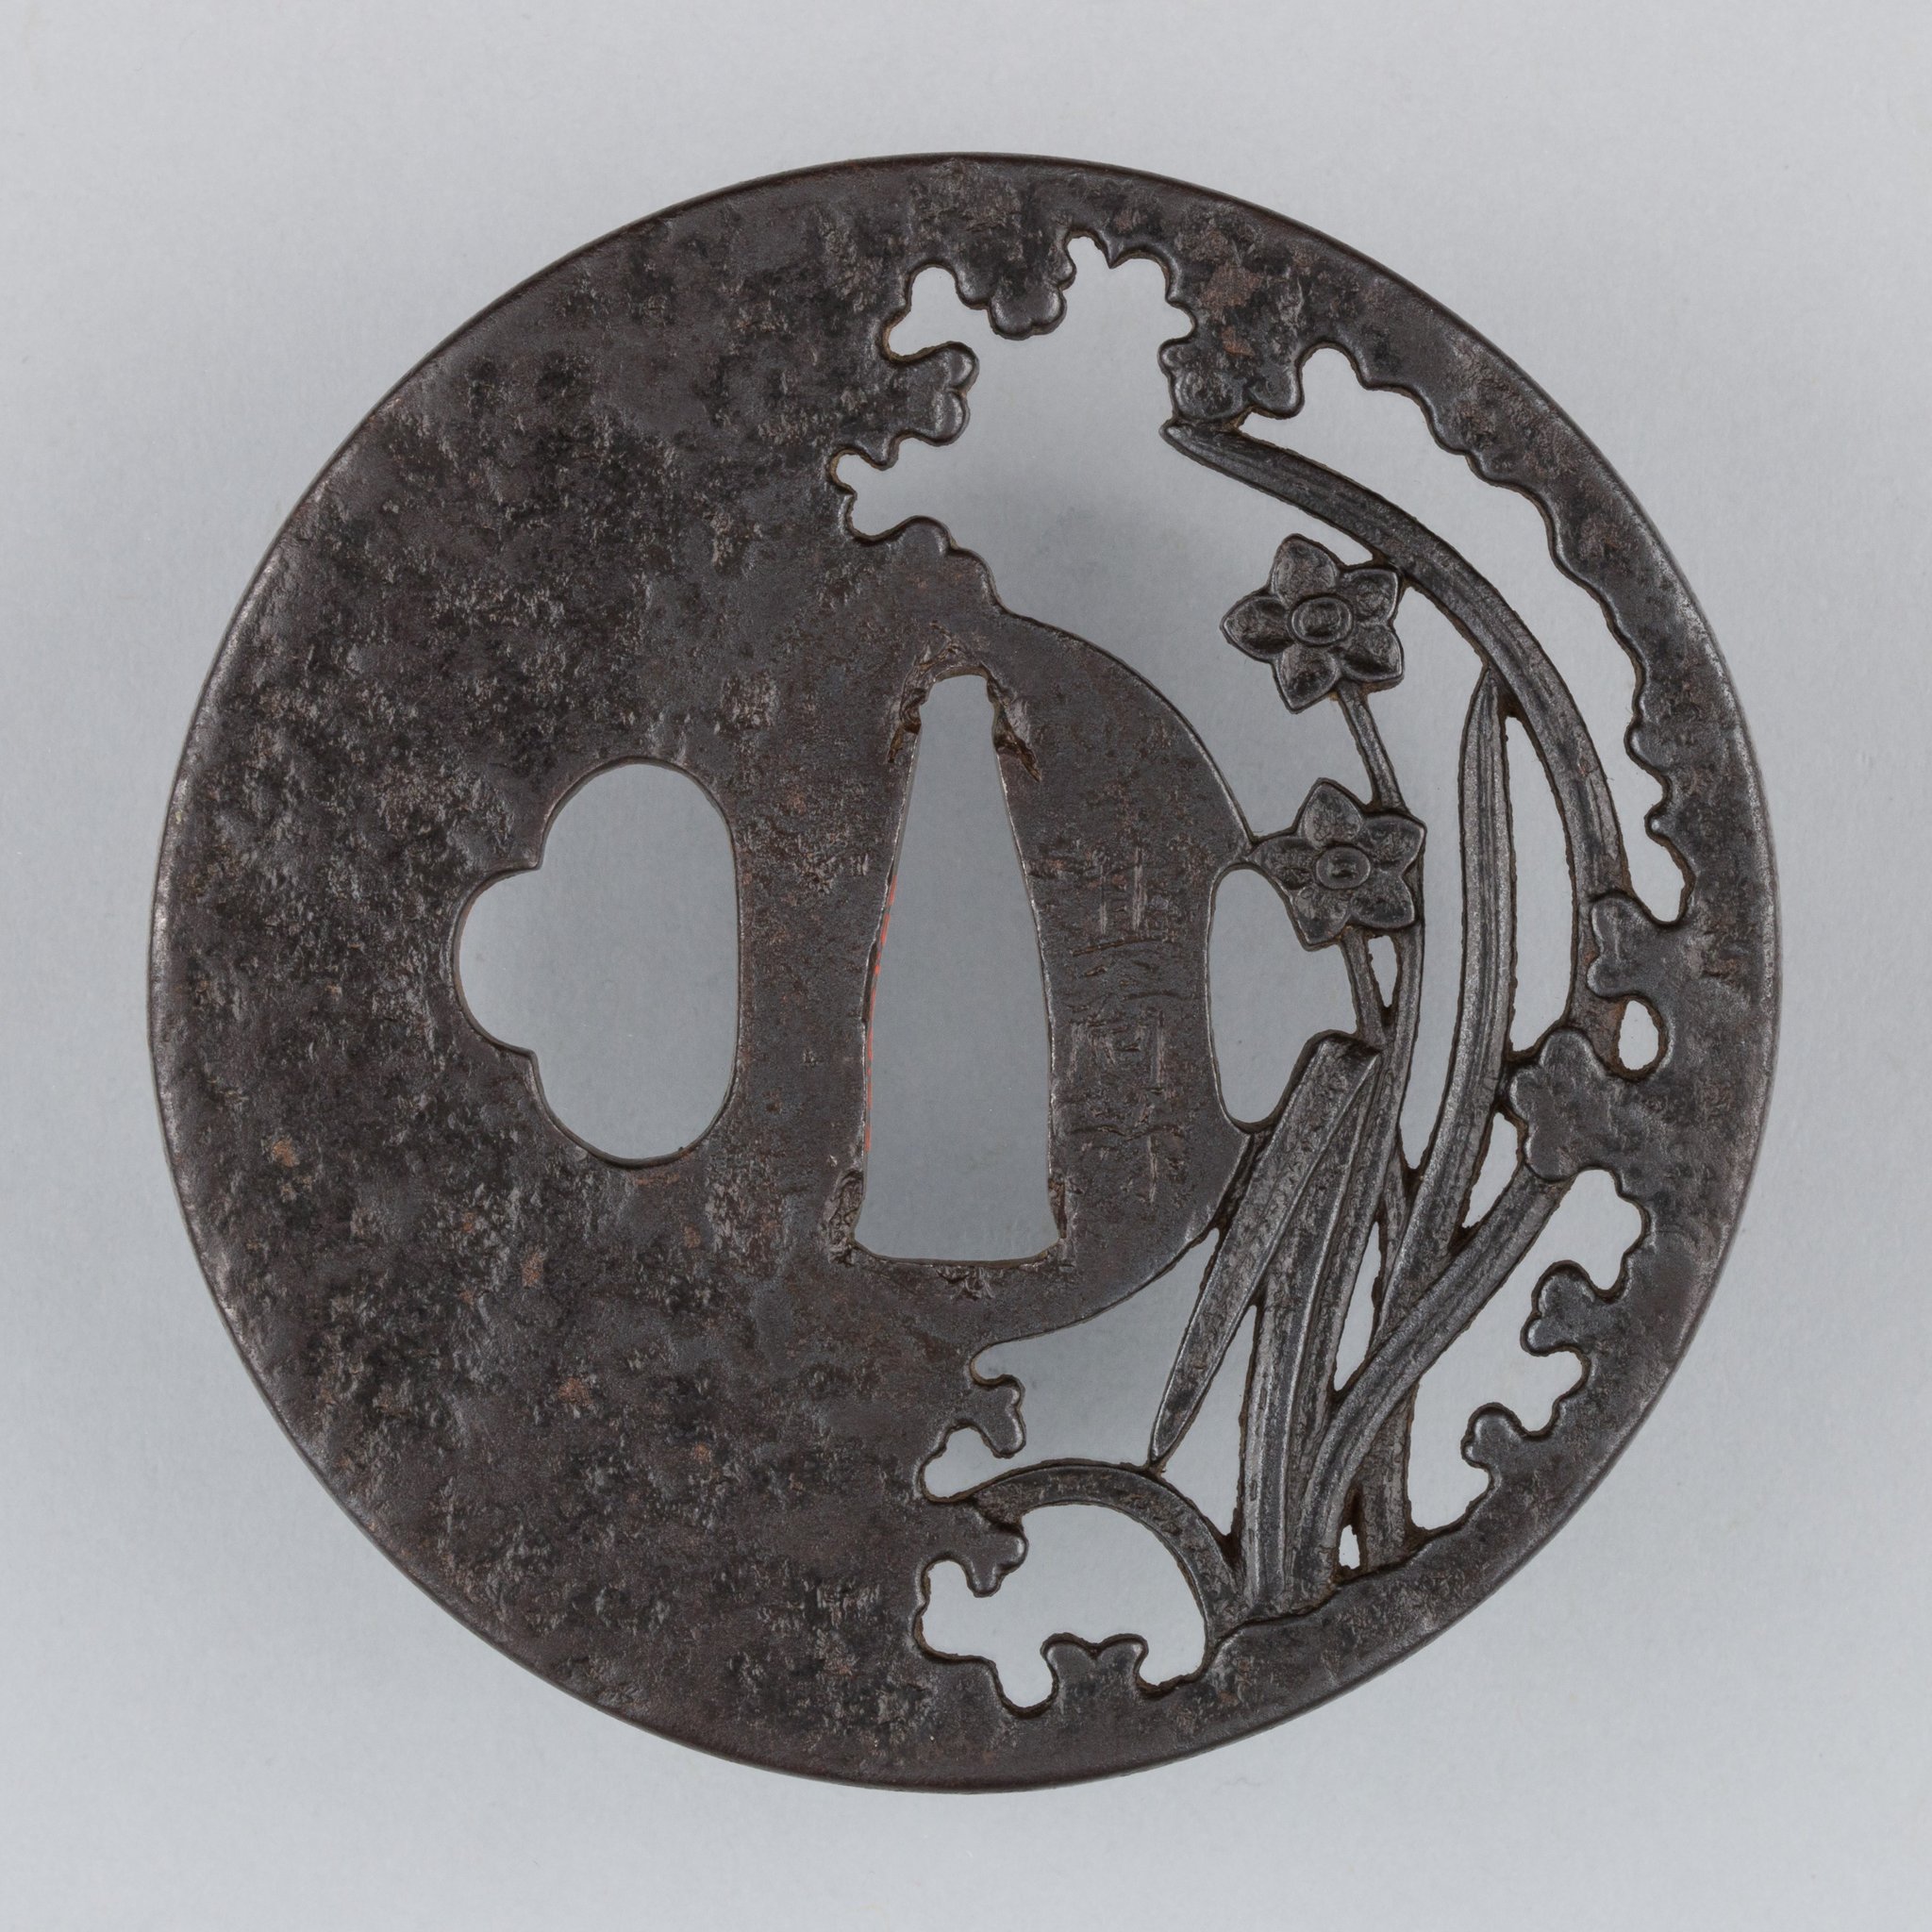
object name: sword guard tsuba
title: Sword Guard (Tsuba)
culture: japanese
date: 1667-1700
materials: copper, iron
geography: japan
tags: flowers